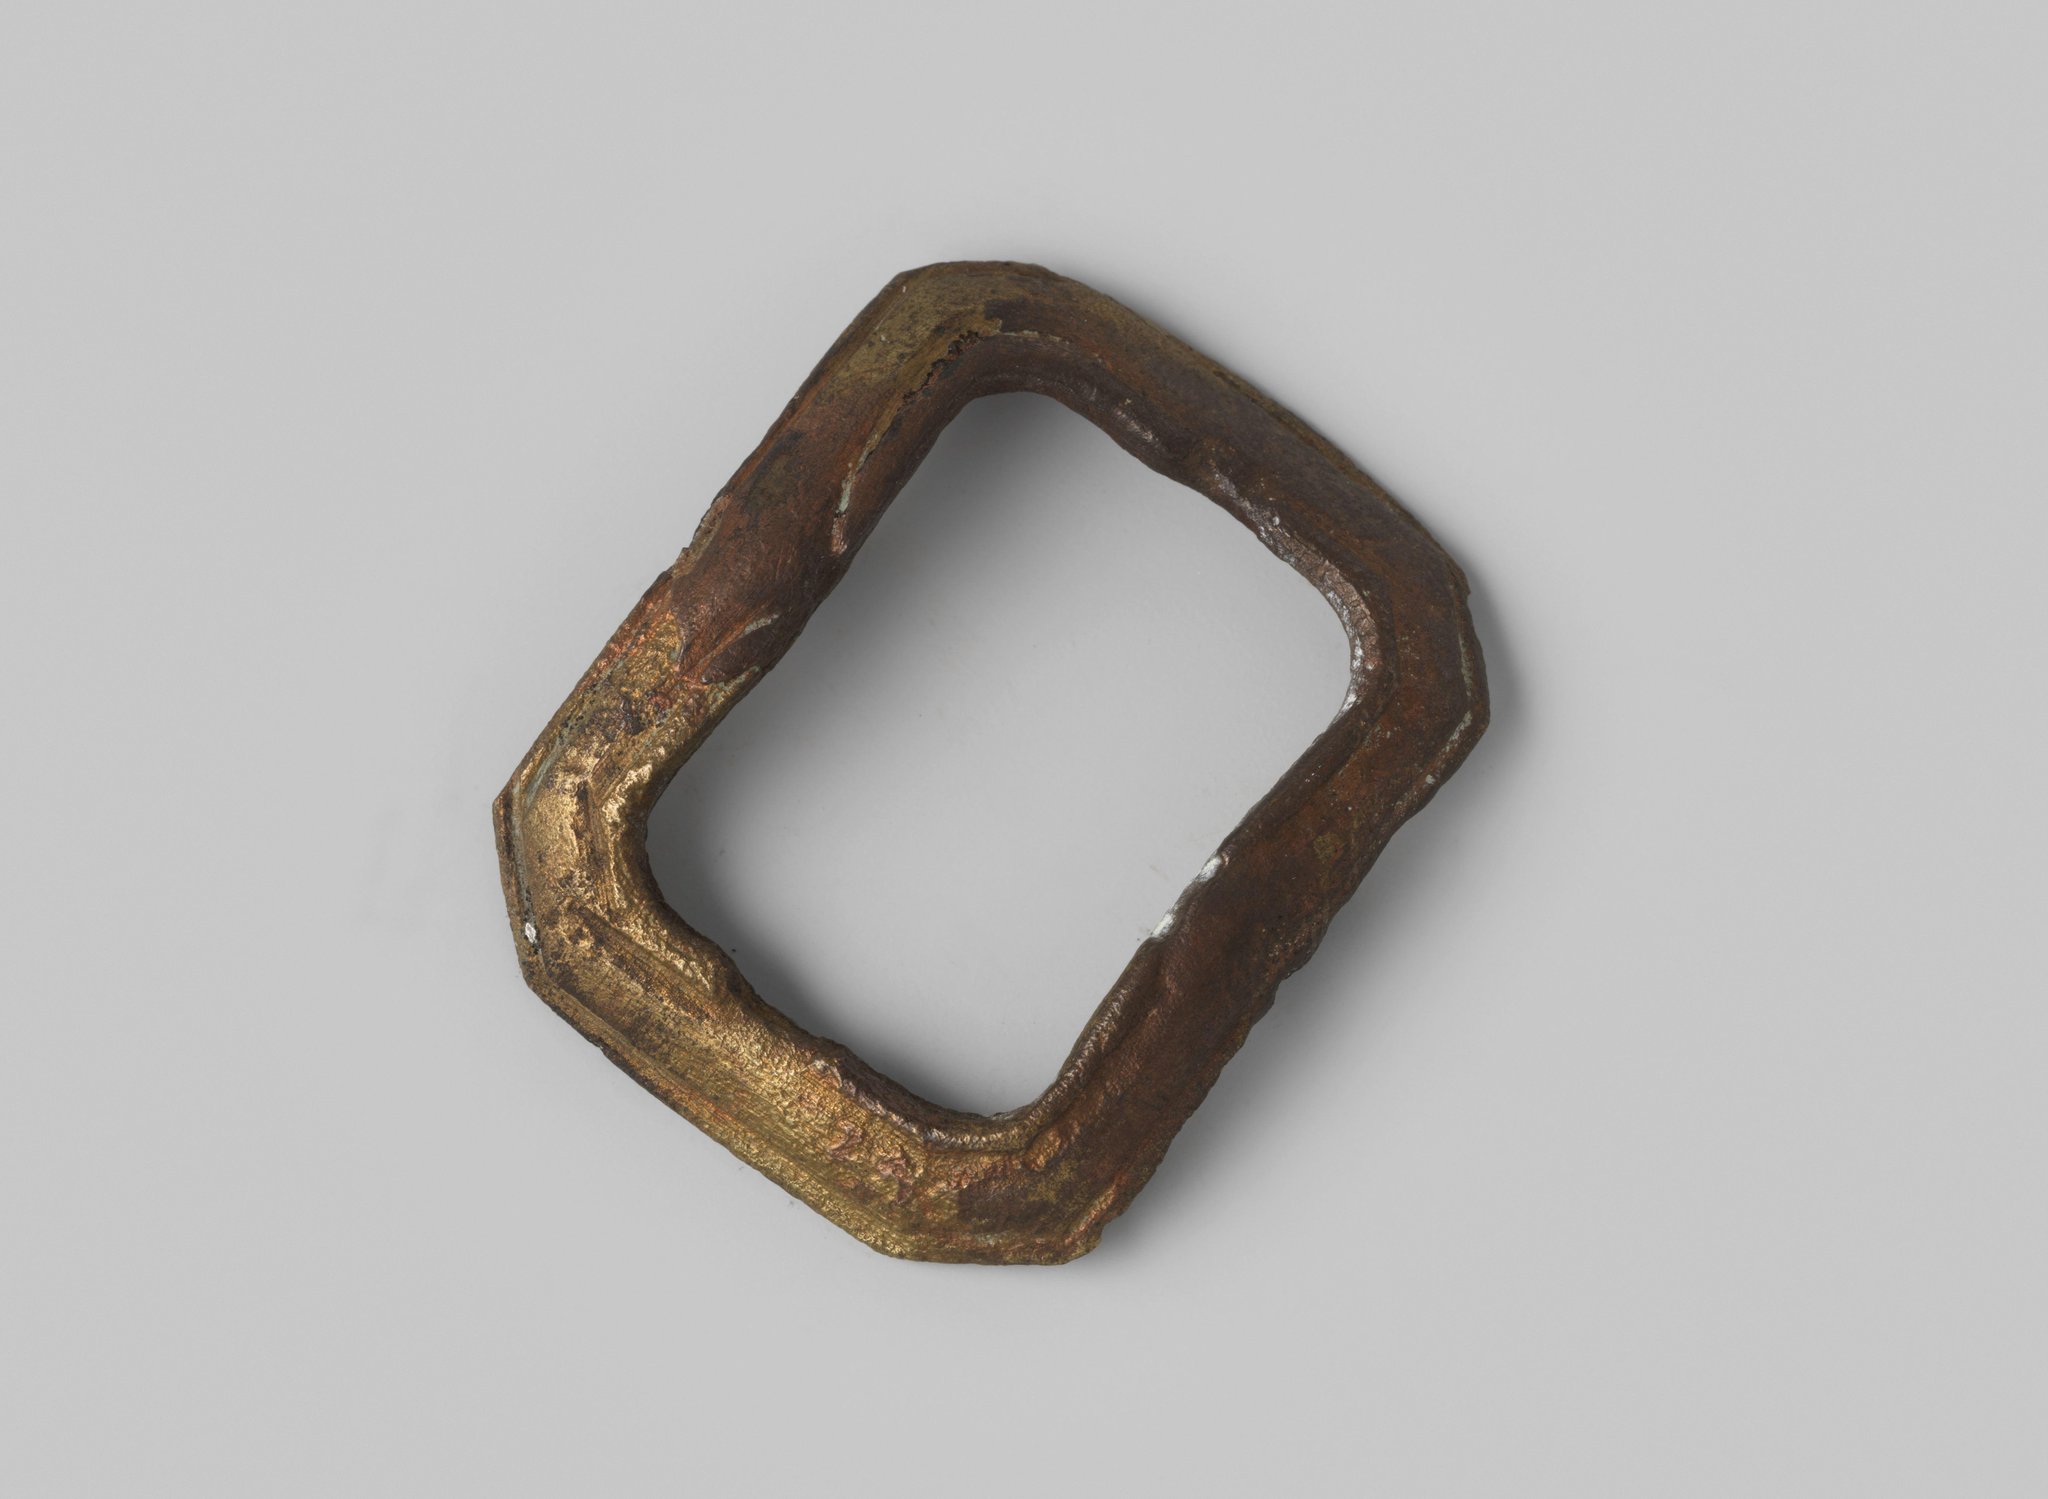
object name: shoe buckle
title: Schoengesp uit het wrak van de Oost-Indiëvaarder Hollandia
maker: Anonymous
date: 1700-1743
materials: copper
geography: netherlands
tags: verenigde oostindische compagnie, hollandia (schip), annet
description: Buckle, chape buckle, shoe buckle; ring, id. NG-1980-27-H-1038.